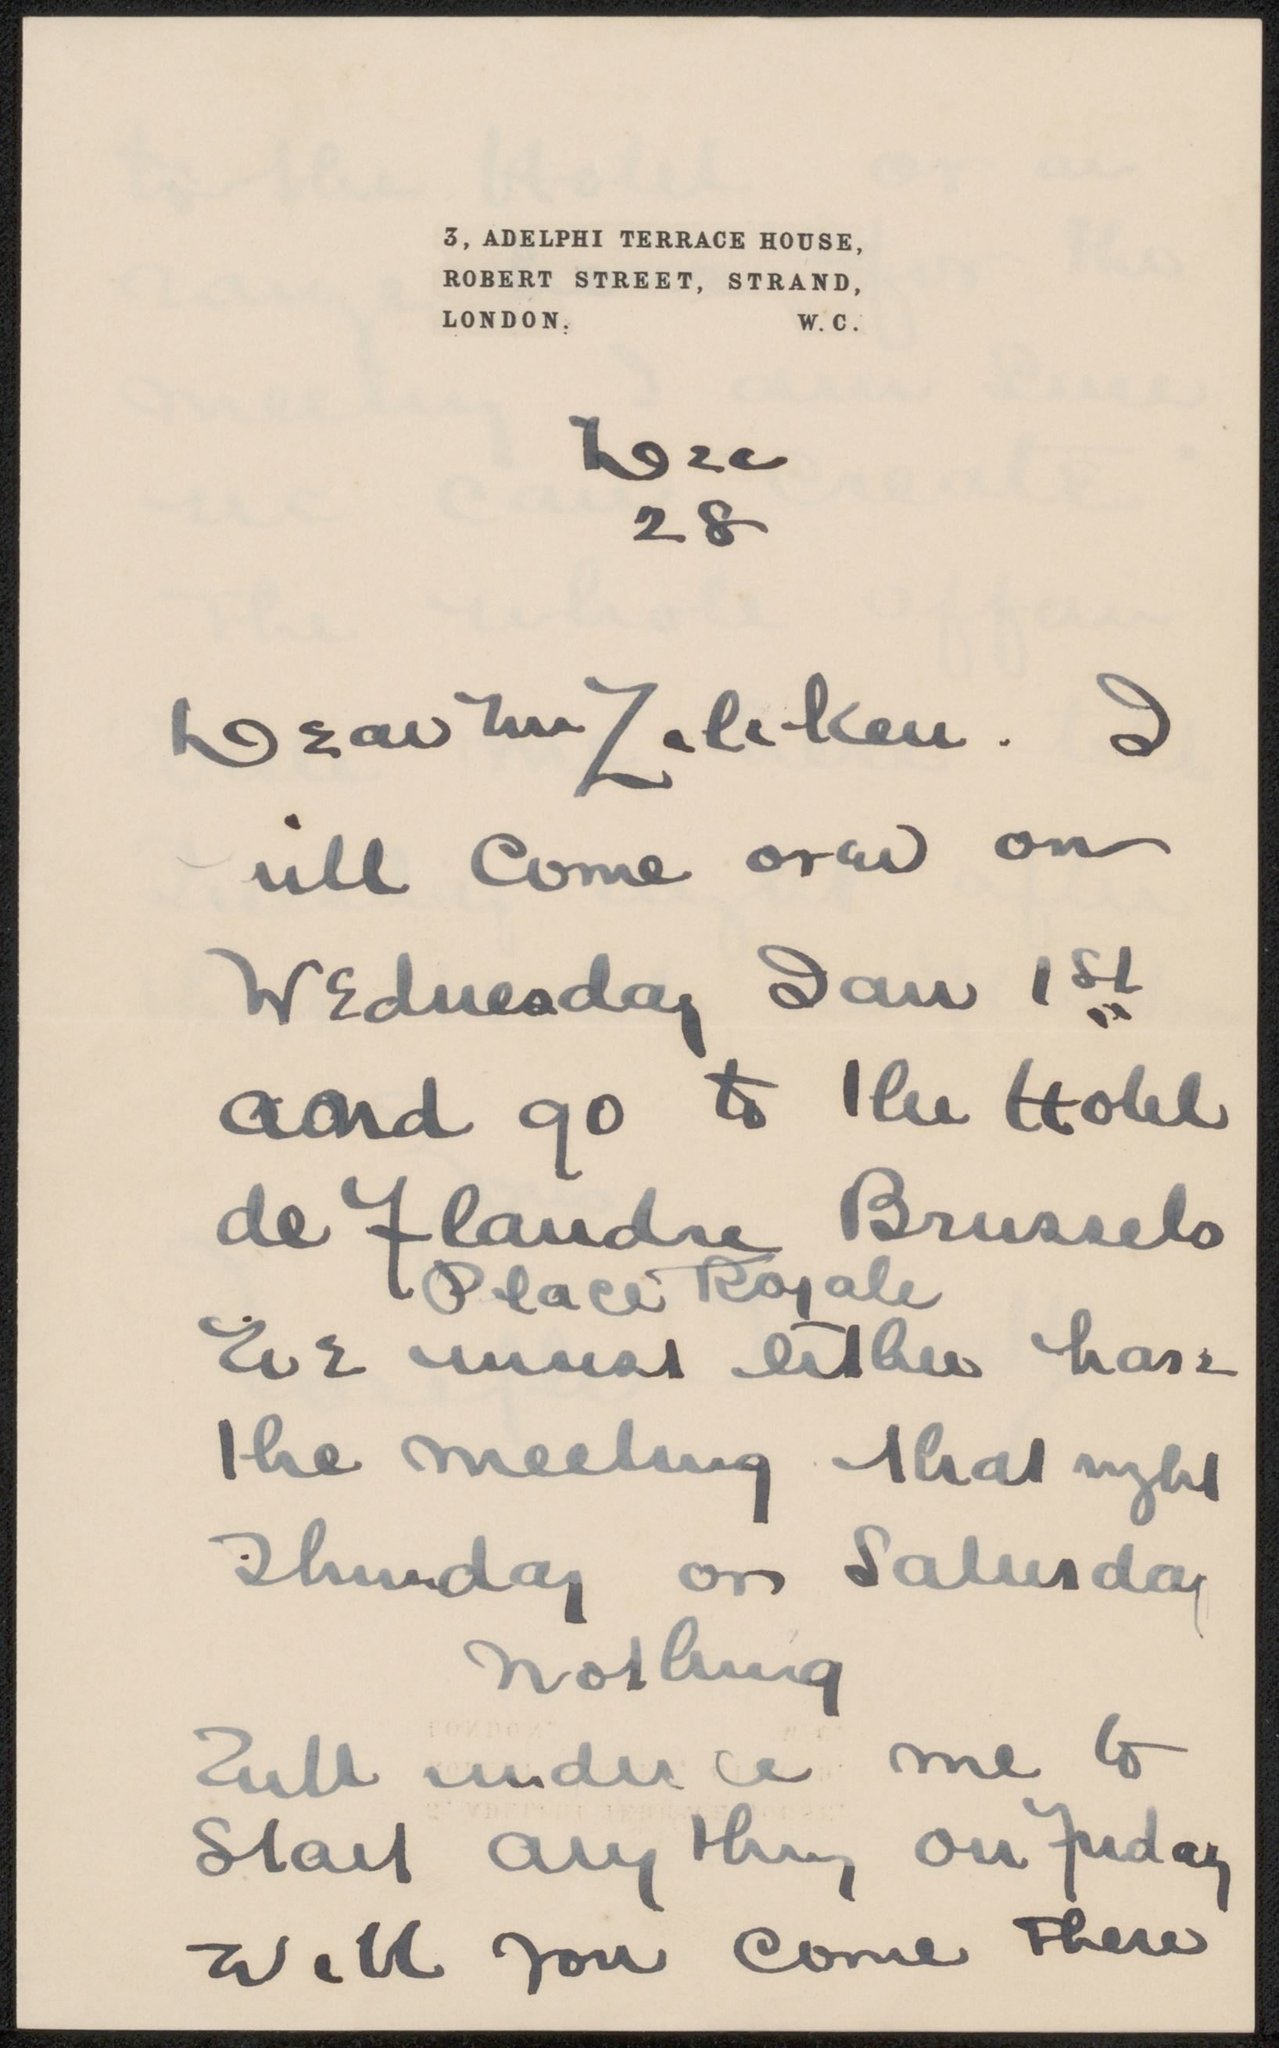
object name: letter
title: Brief aan Philip Zilcken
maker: joseph pennell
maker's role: print maker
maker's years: 1857-1926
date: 1912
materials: ink, paper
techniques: pen, printing, writing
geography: london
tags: the hague, draughtsman, philip zilcken, brussels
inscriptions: watermark, collector's mark: ‘RPK’